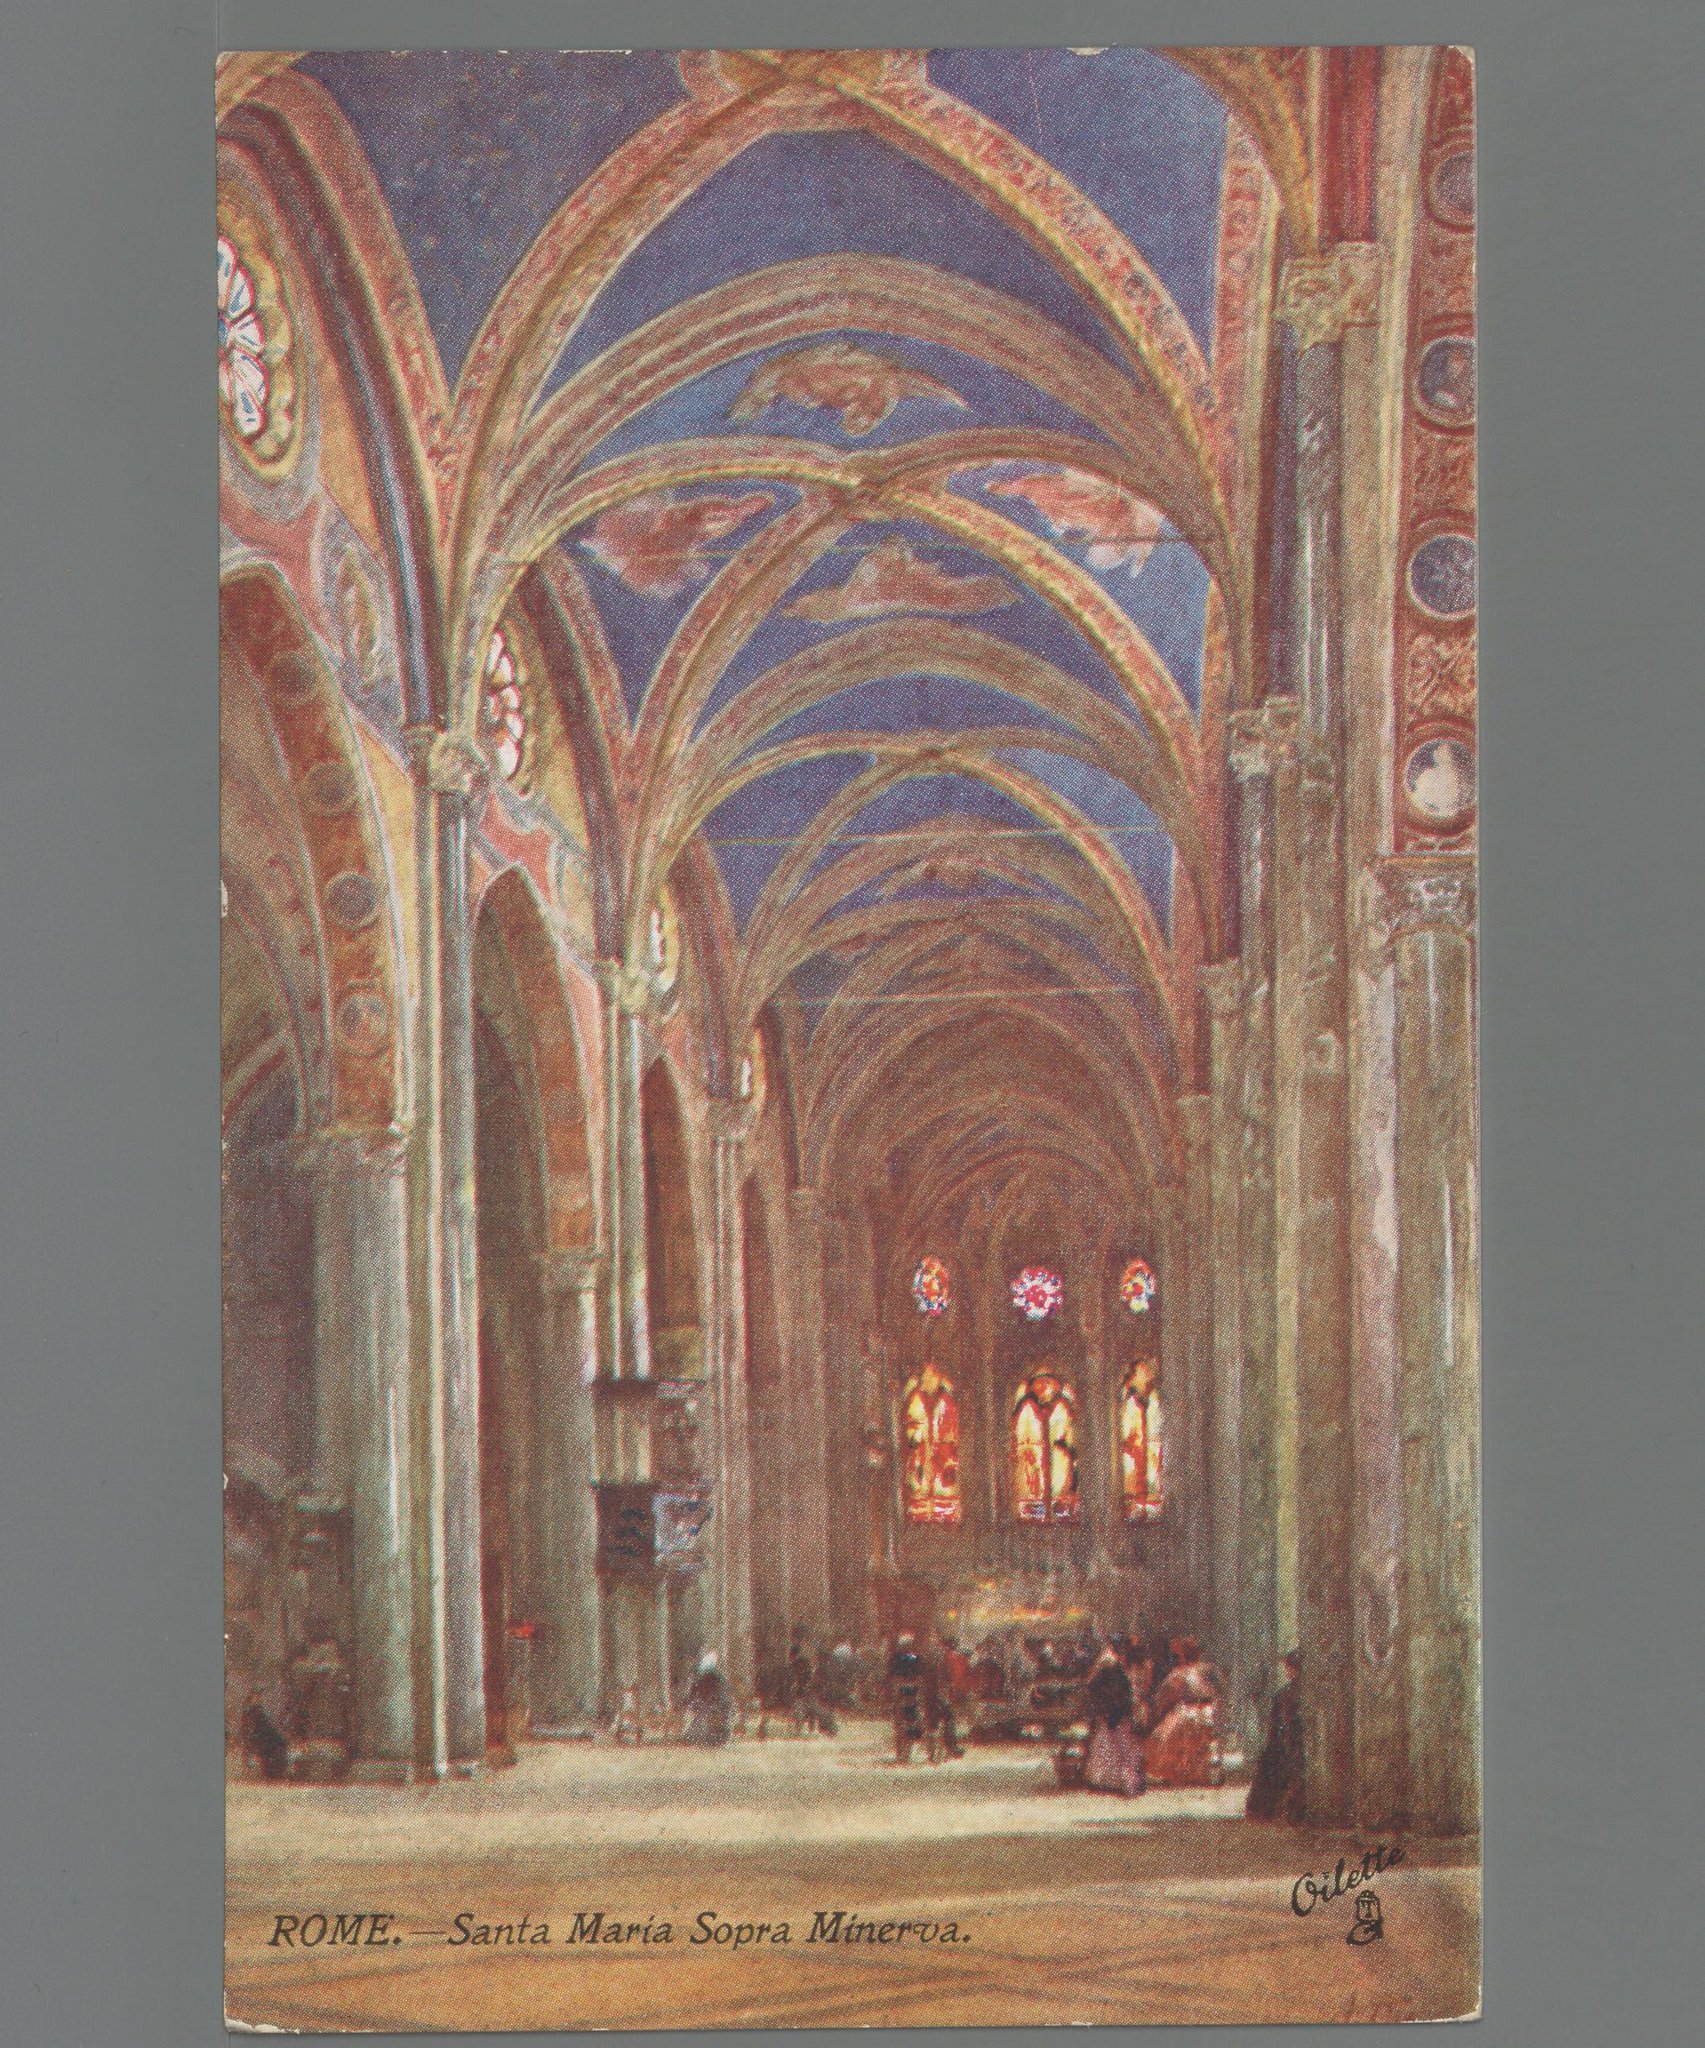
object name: reproduction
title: Rome. Series III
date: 1908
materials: cardboard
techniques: three-color autotype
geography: london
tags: interior of church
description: Afbeelding afkomstig uit: Malleson, Hope, en Mark Turner. Rome Painted By Alberto Pisa. Londen: Adam en Charles Black, 1905.